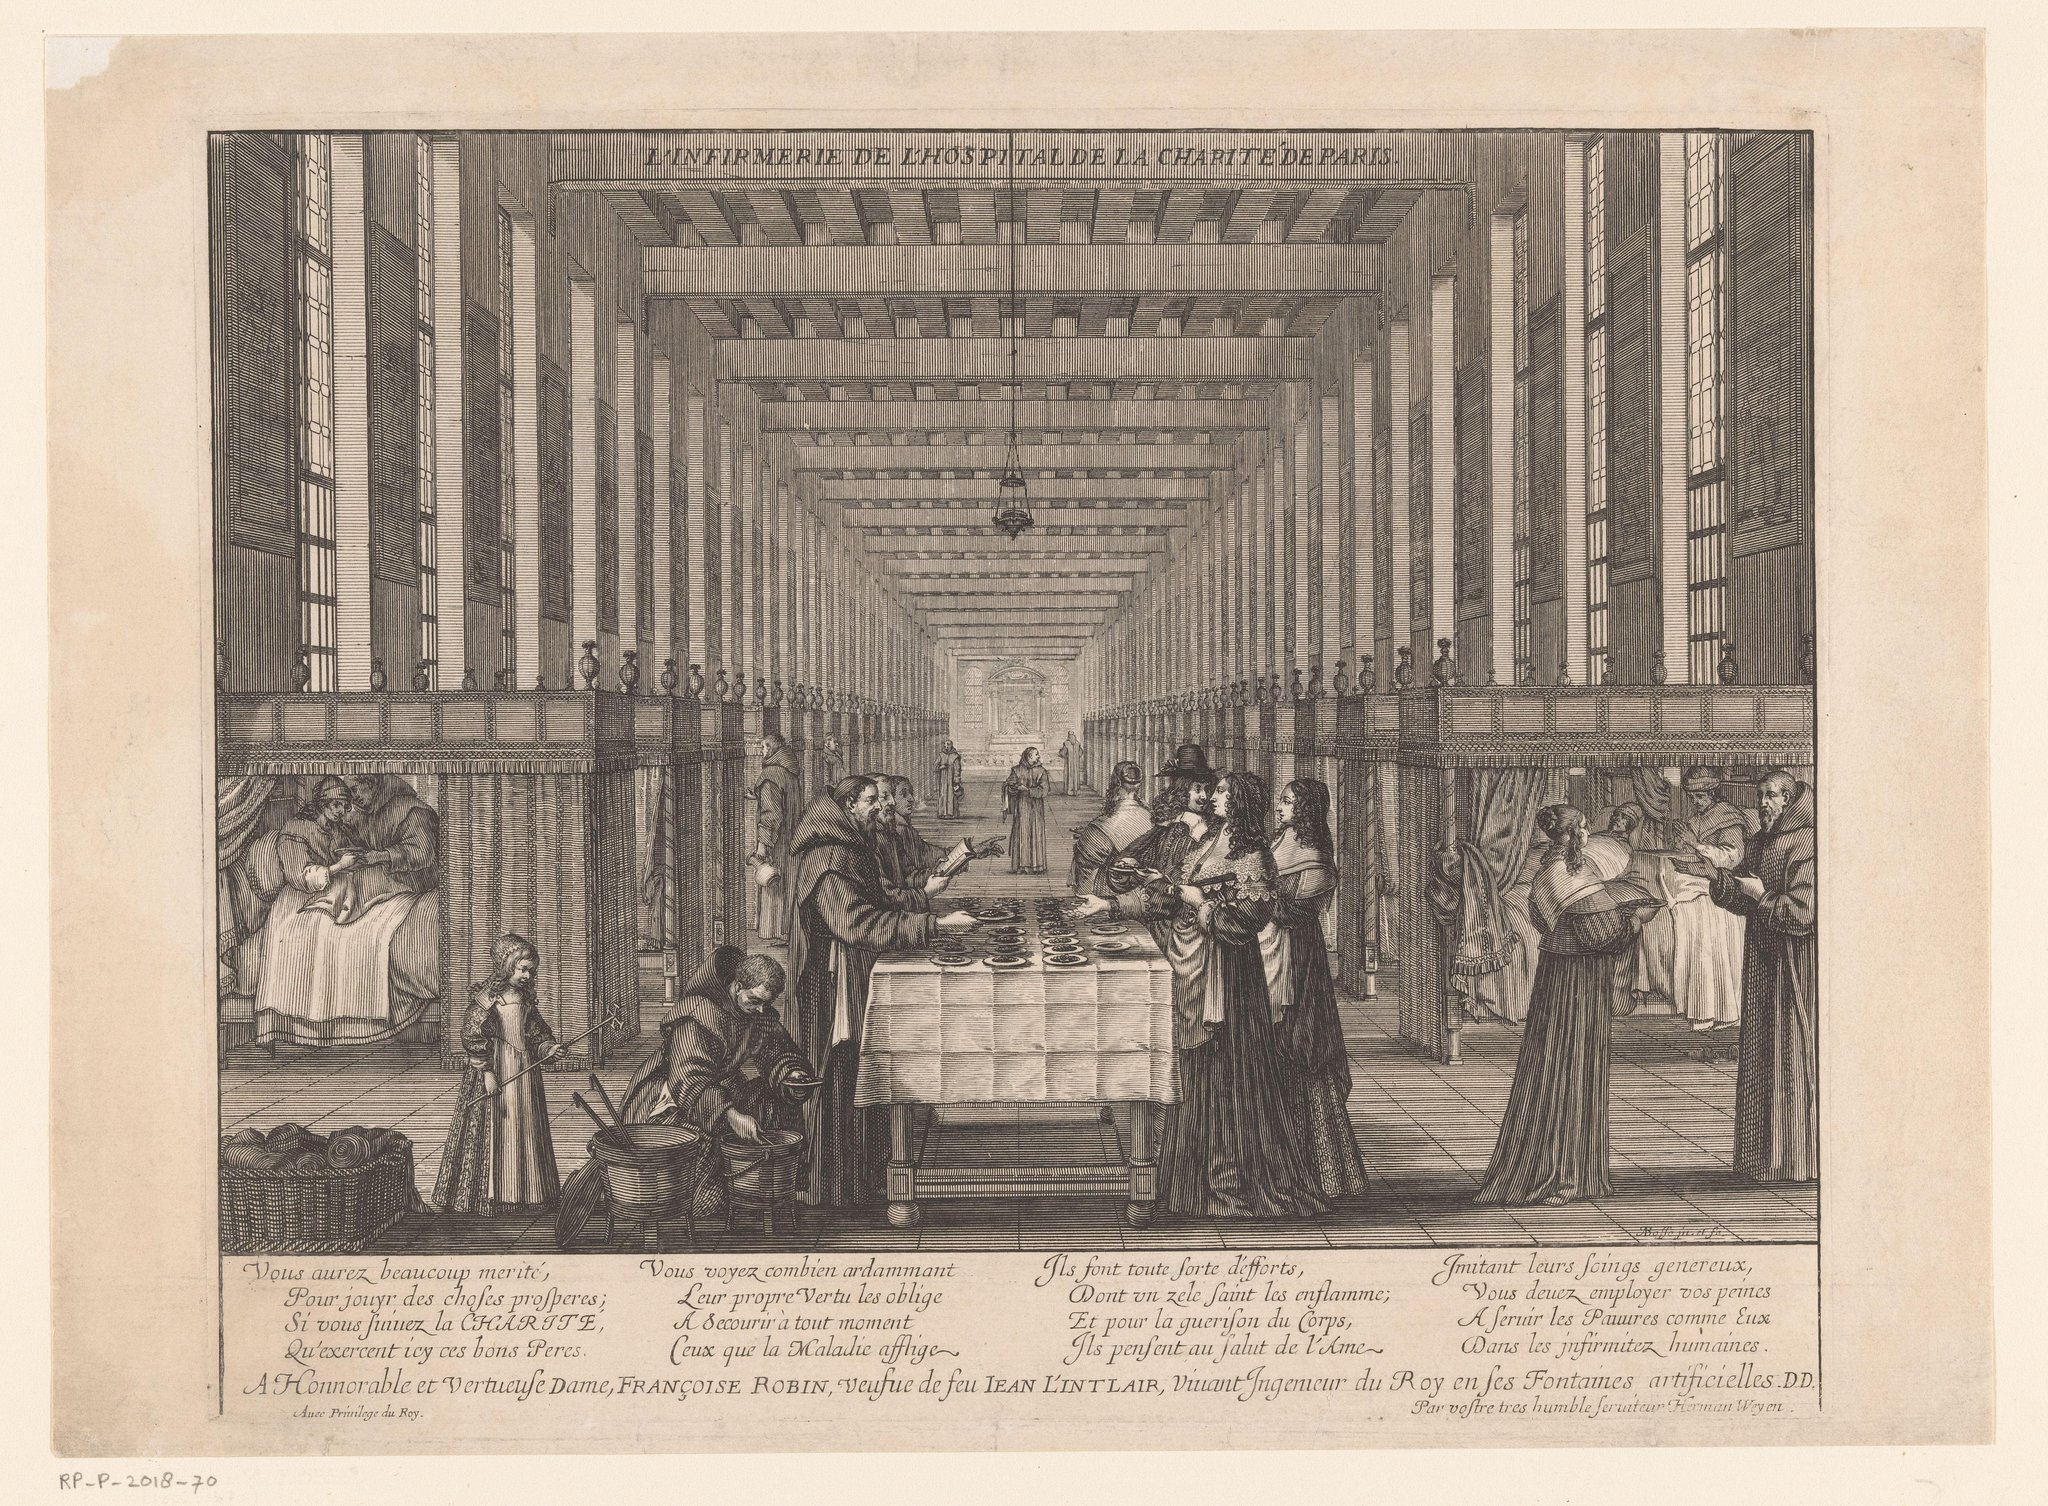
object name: print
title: L'Infirmerie de l'hospital de la charité de Paris.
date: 1642-1643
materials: paper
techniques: engraving, etching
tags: physician, doctor, hospital, charitable works, paris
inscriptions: collector's mark: Lugt 2228